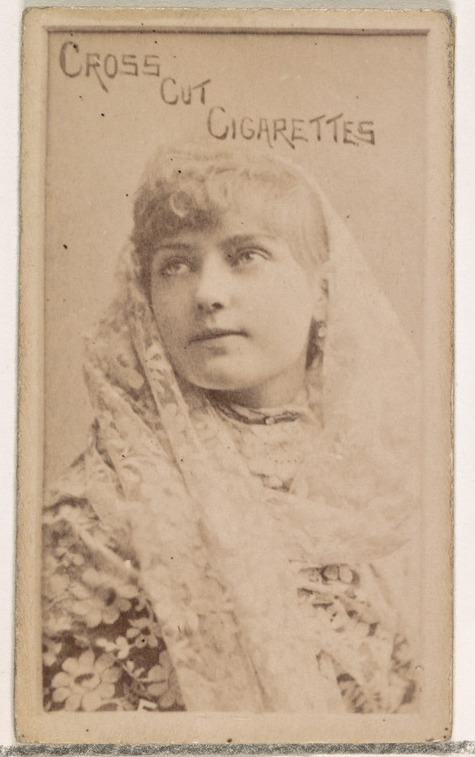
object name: print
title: Card Number 5, Lillian Russell, from the Actors and Actresses series (N145-1) issued by Duke Sons & Co. to promote Cross Cut Cigarettes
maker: w. duke, sons & co.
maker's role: publisher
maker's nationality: american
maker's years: 1870-1920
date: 1880-1889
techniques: albumen silver print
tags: portraits,women,actresses